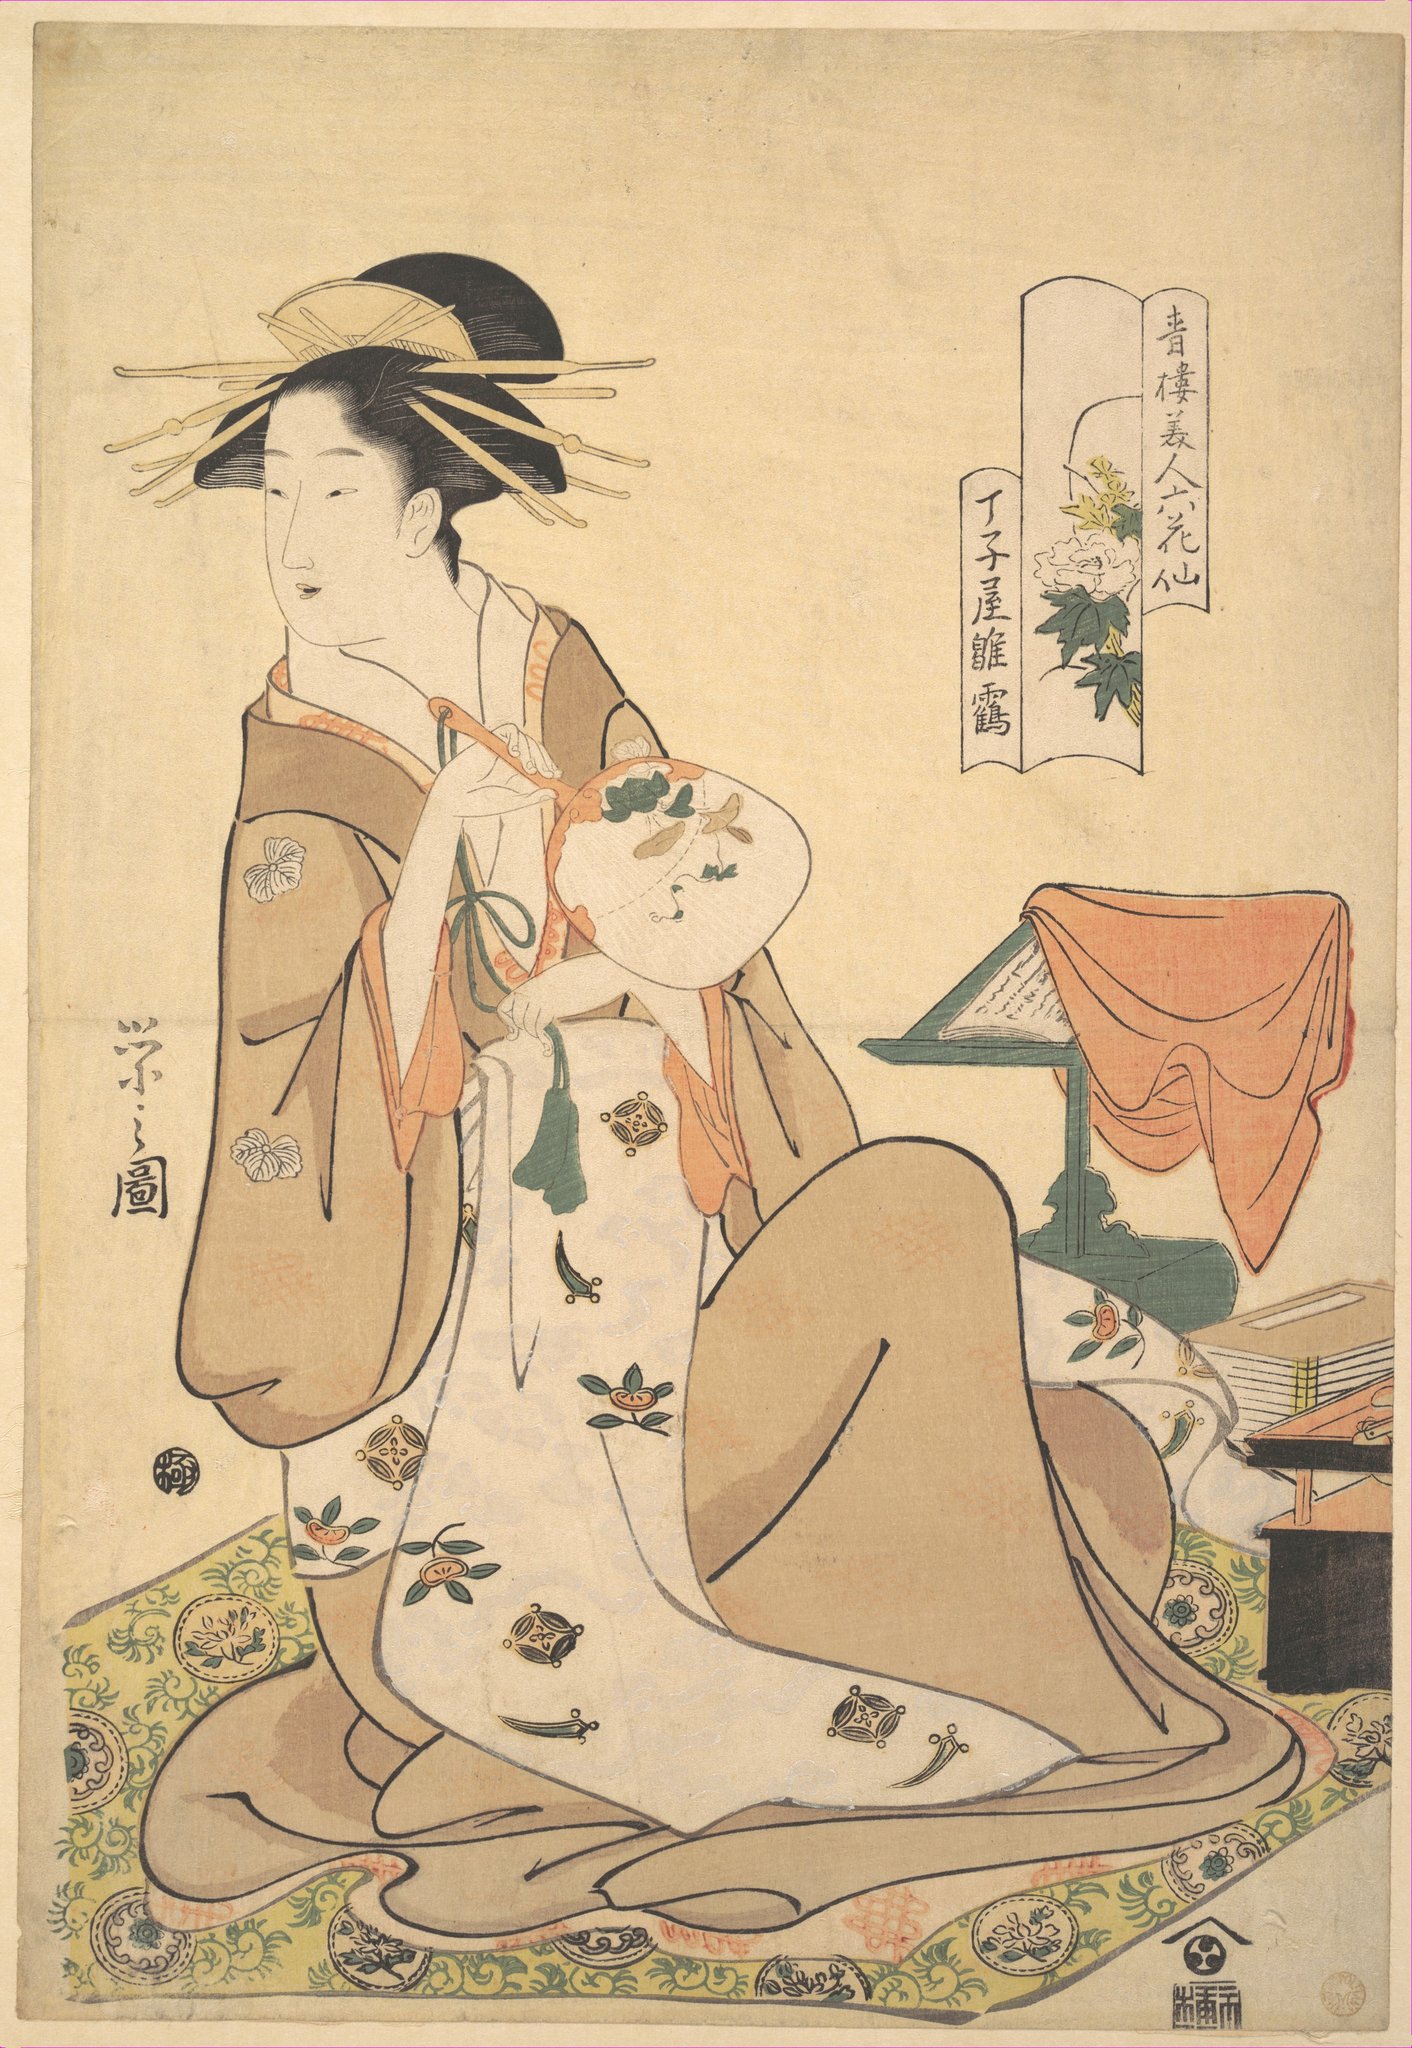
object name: print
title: The Oiran Hinazuru of Chōjiya Holding a Round Fan (Uchiwa)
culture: japanese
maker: chōbunsai eishi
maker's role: artist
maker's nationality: japanese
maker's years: 1756-1829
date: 1794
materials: ink, paper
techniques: woodblock print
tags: fans,women